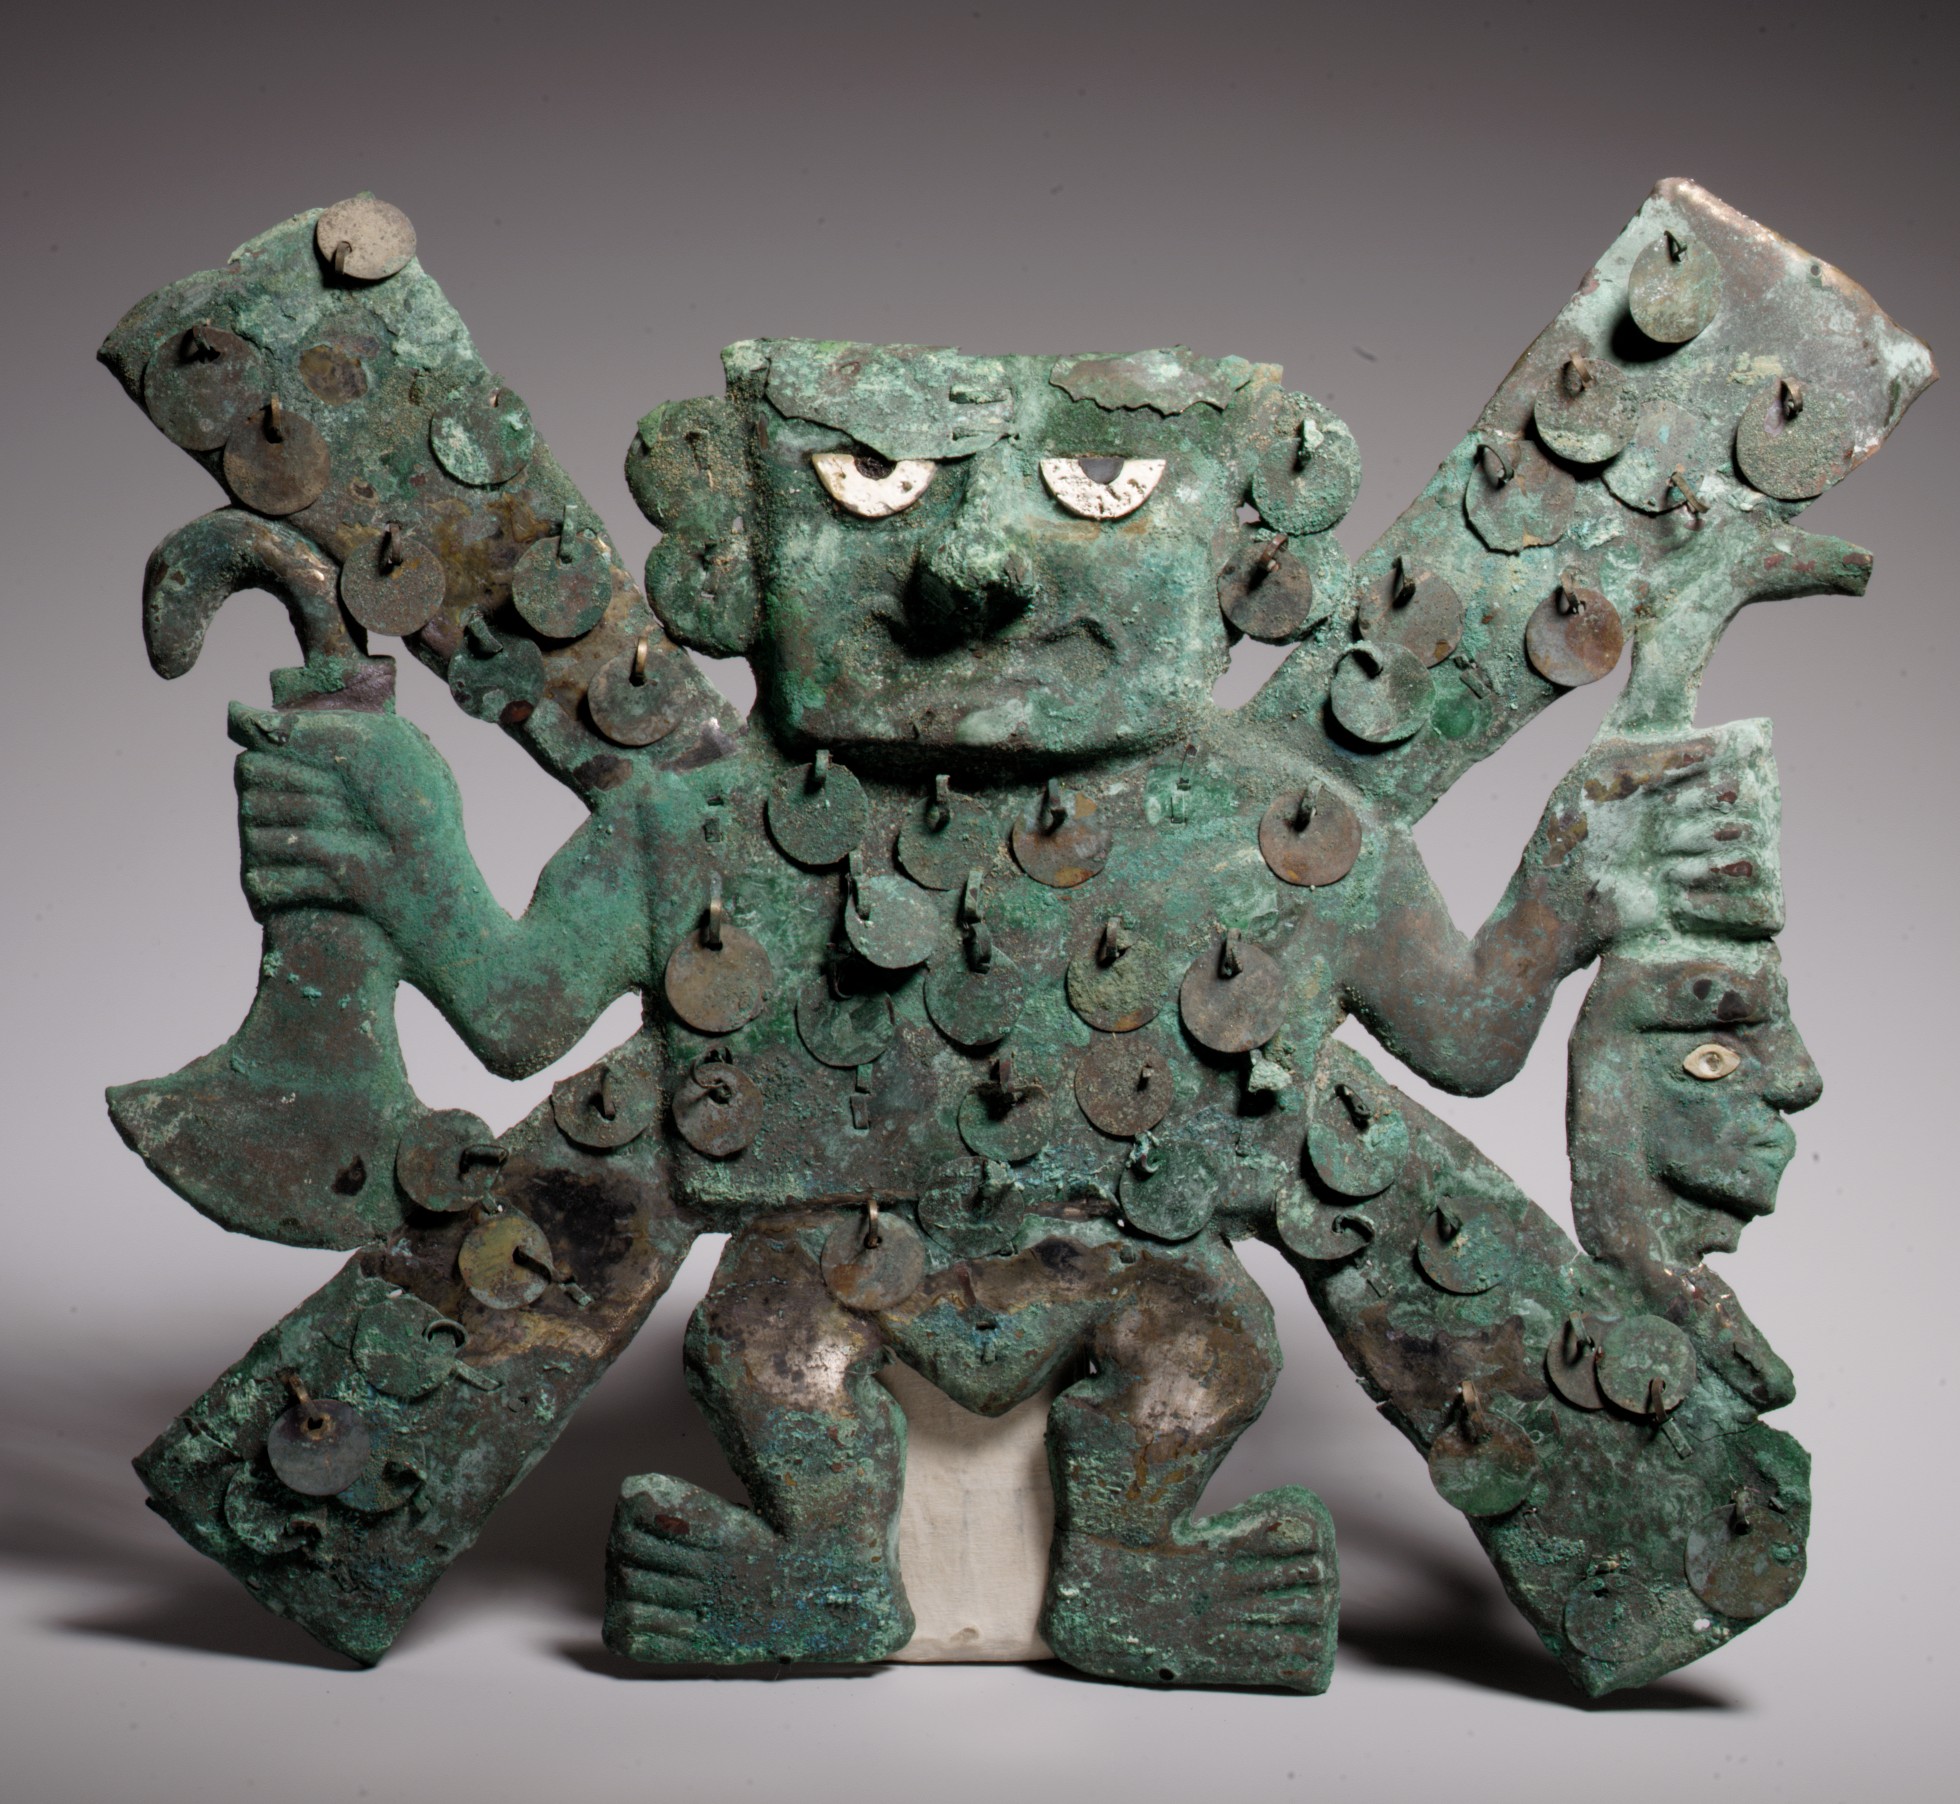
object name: ornament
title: Decapitator plaque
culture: moche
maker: moche artist(s)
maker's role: artist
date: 500-800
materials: shell, metal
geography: peru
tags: weapons,heads,men